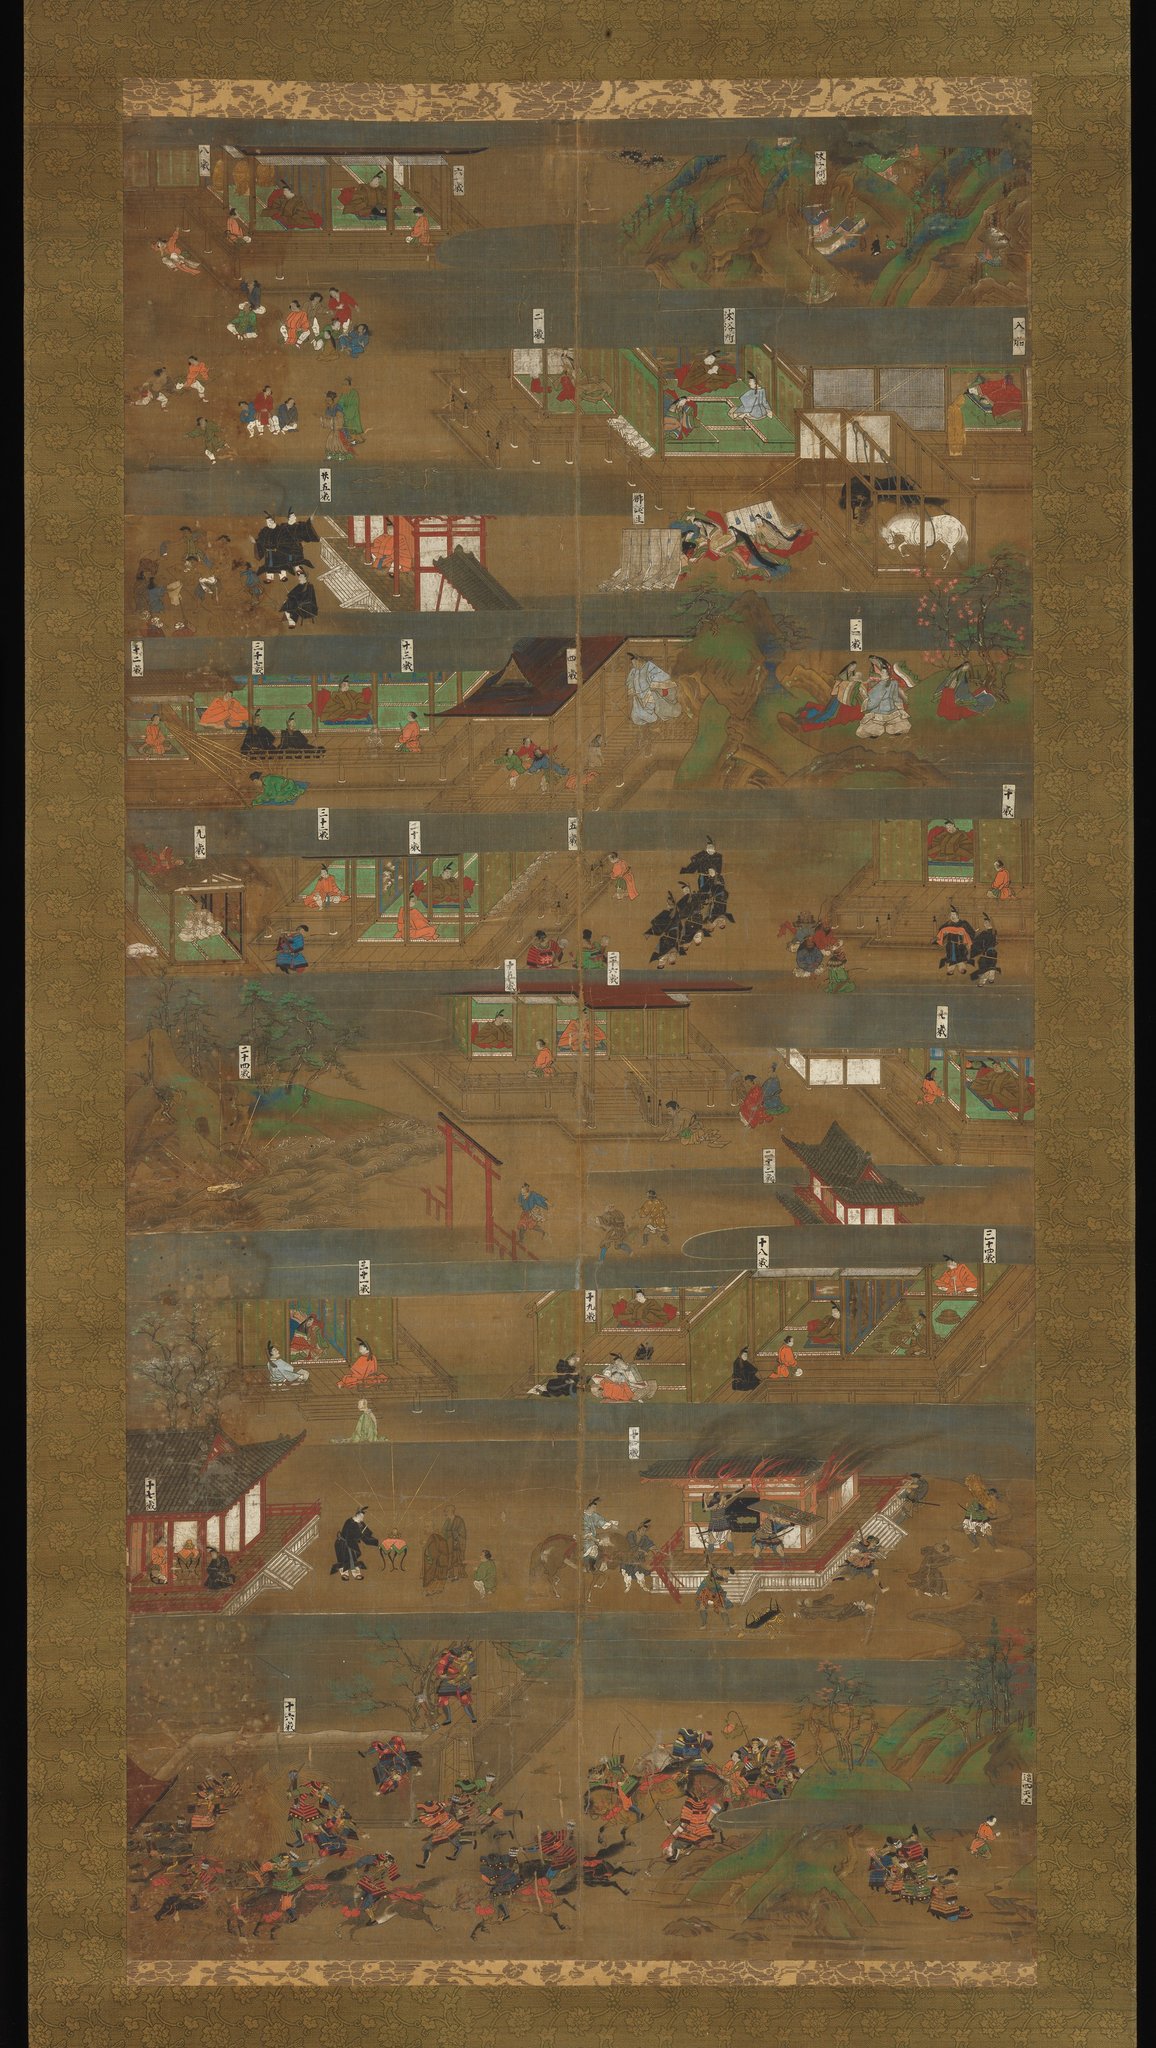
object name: hanging scroll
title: Illustrated Biography of Prince Shōtoku (Shōtoku Taishi e-den)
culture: japanese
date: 1301-1400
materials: gold, ink, silk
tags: interiors,battles,men,women,horses,buddhism